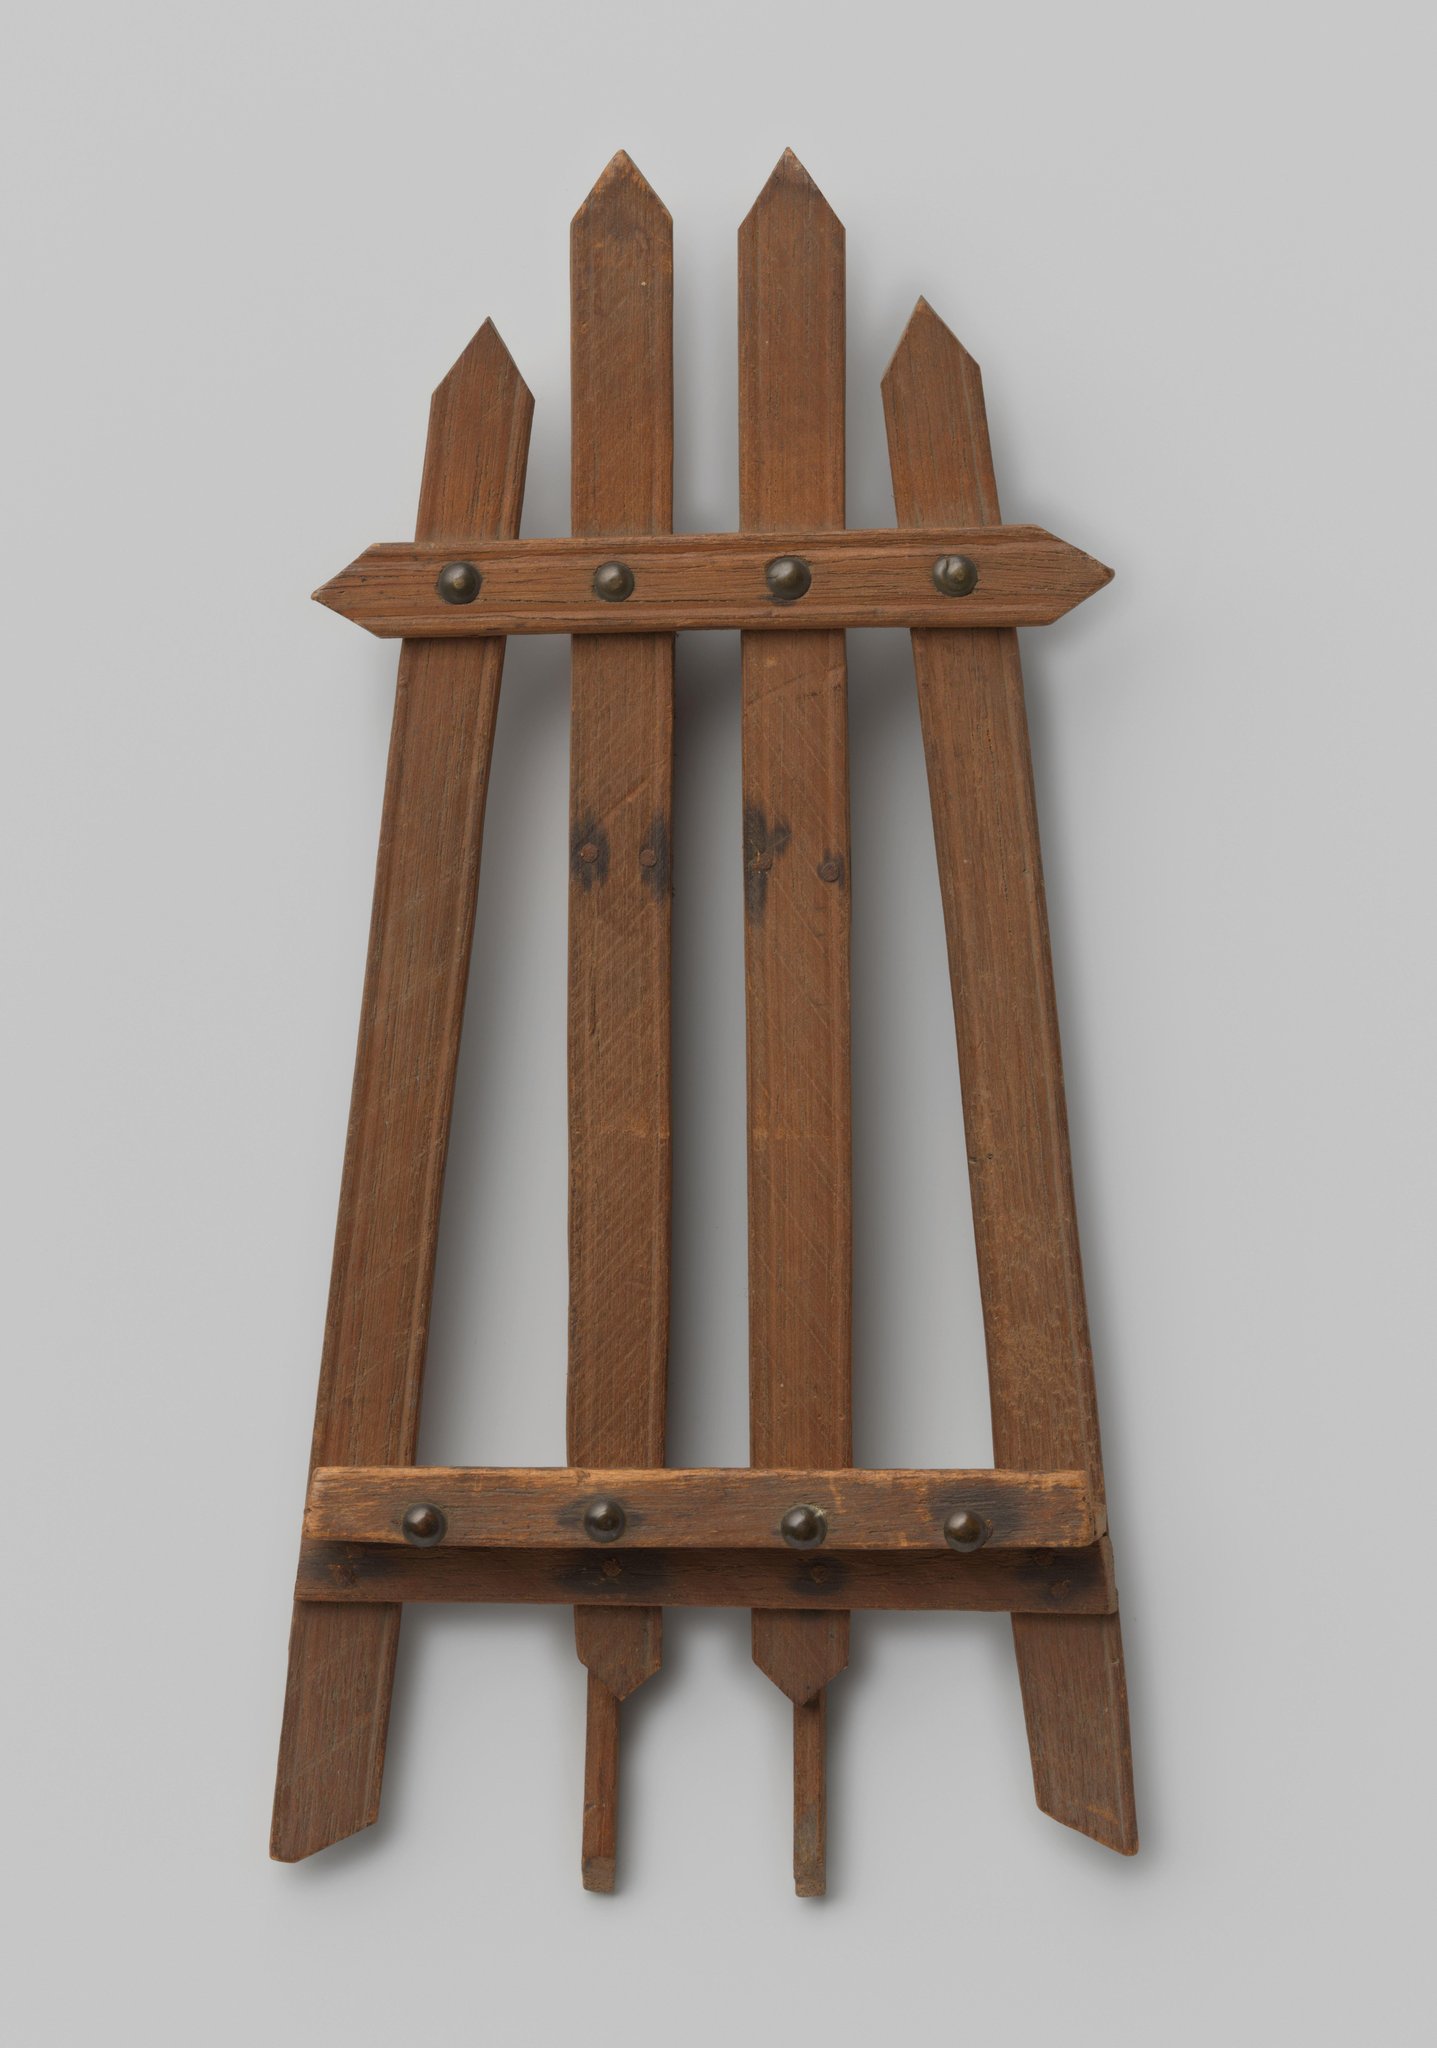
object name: standaard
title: Fotostandaard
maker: Anonymous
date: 1880-1900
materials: metal, wood